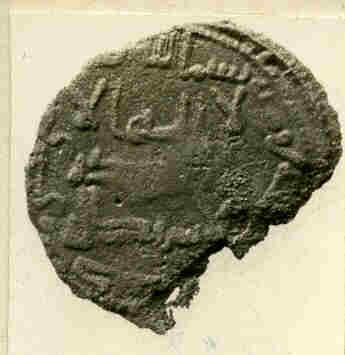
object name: coin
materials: copper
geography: iran